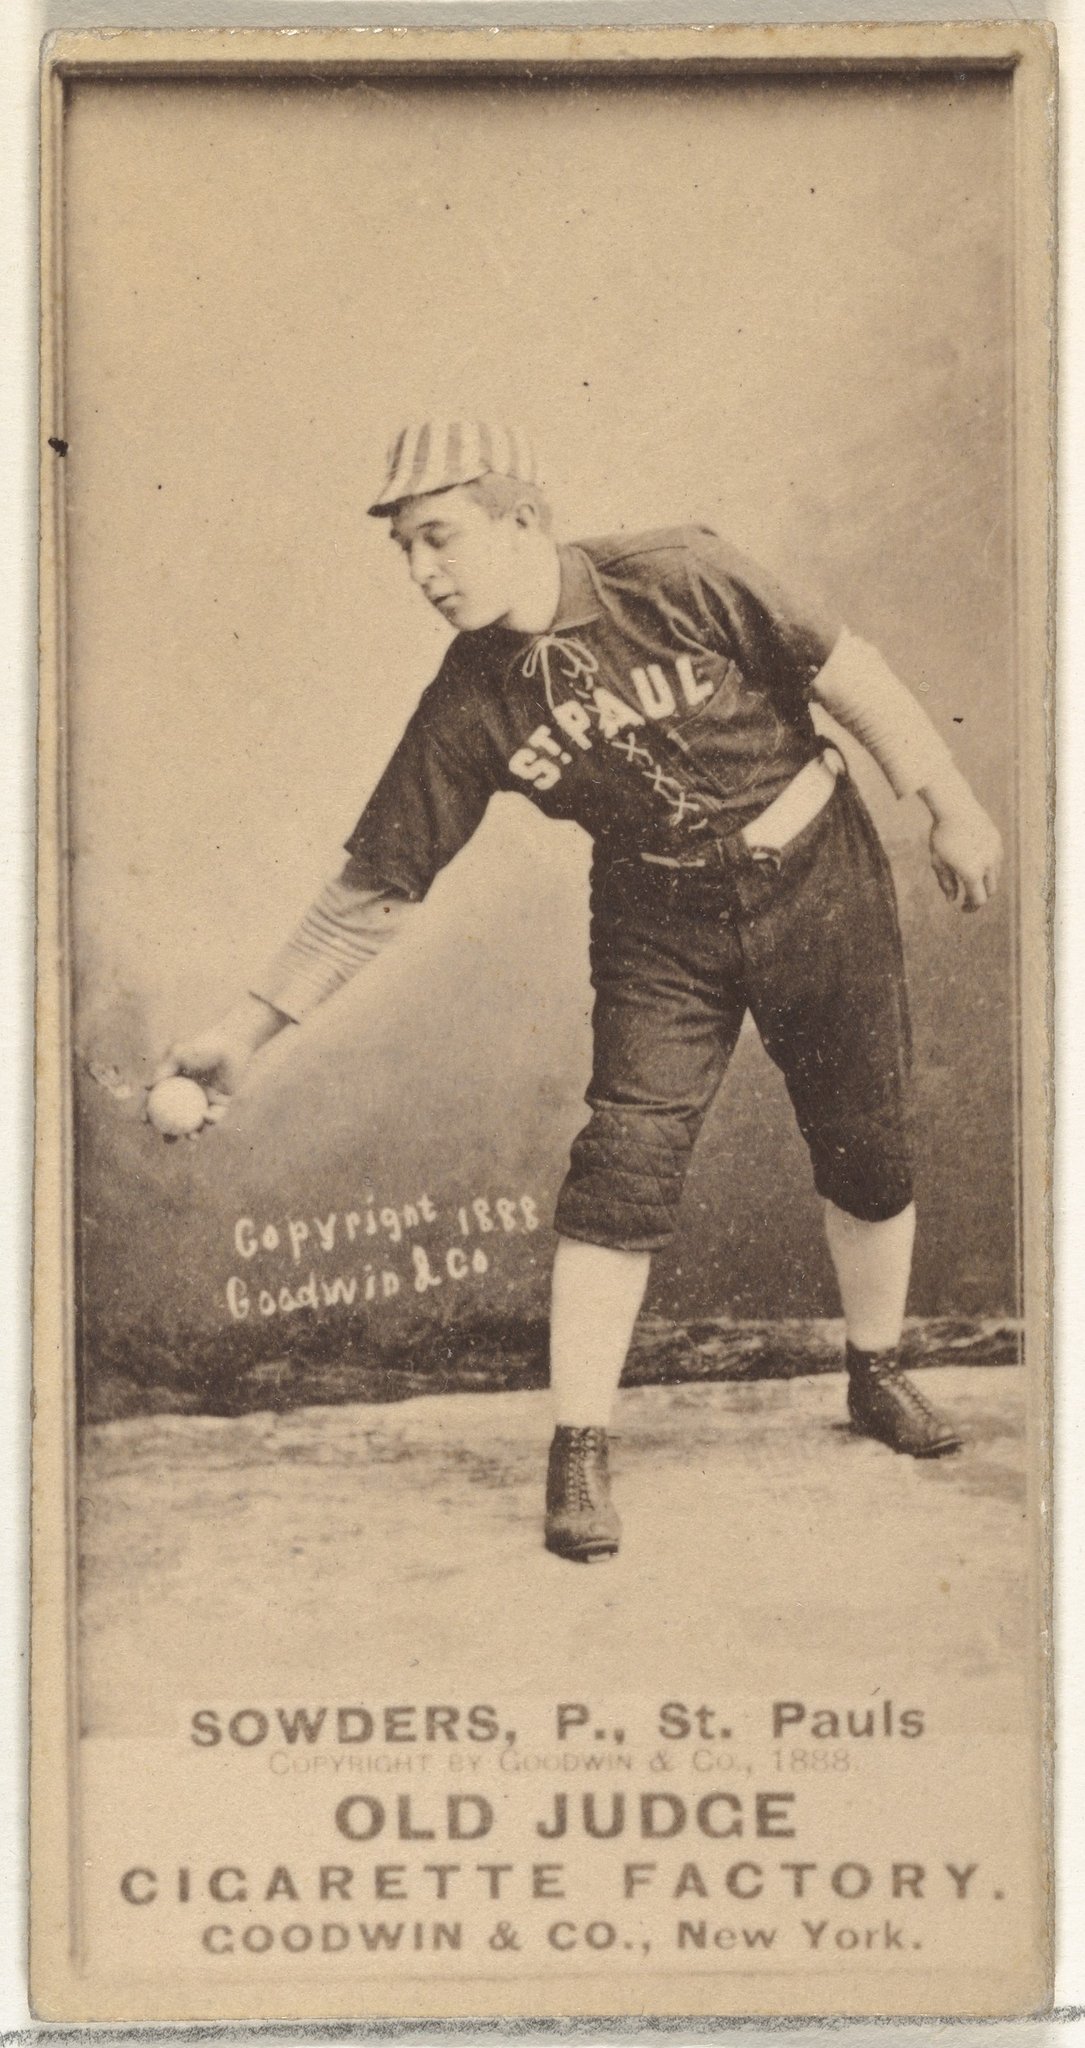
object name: baseball card, photograph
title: John Sowders, Pitcher, St. Paul Apostles, from the Old Judge series (N172) for Old Judge Cigarettes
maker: goodwin & company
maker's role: publisher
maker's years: 1850-1950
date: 1888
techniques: albumen silver print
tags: men,portraits,baseball,athletes